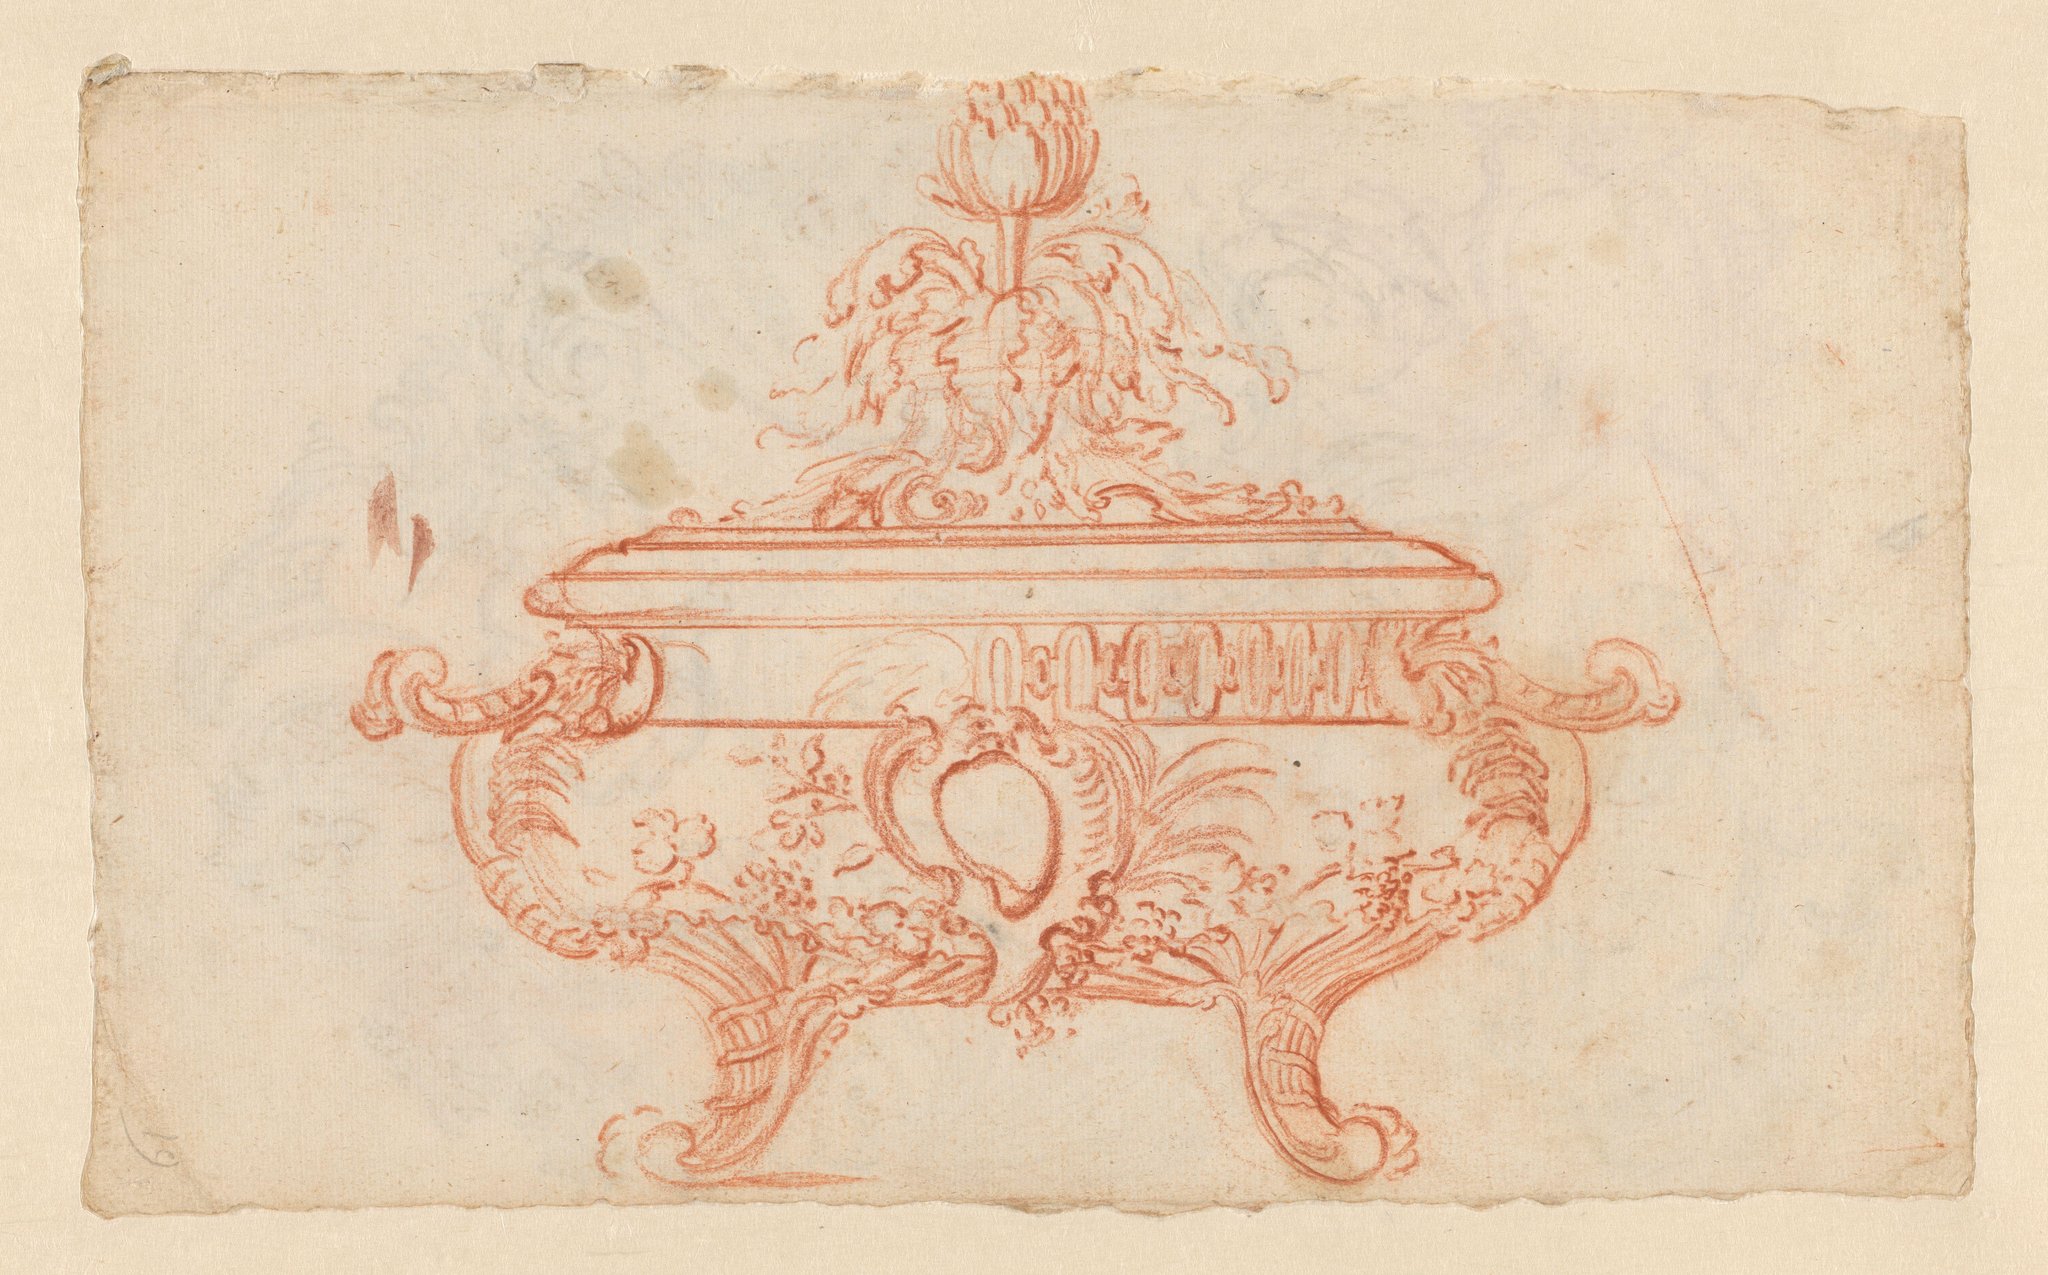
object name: design drawing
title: Ontwerp voor een terrine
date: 1750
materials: chalk, graphite, paper